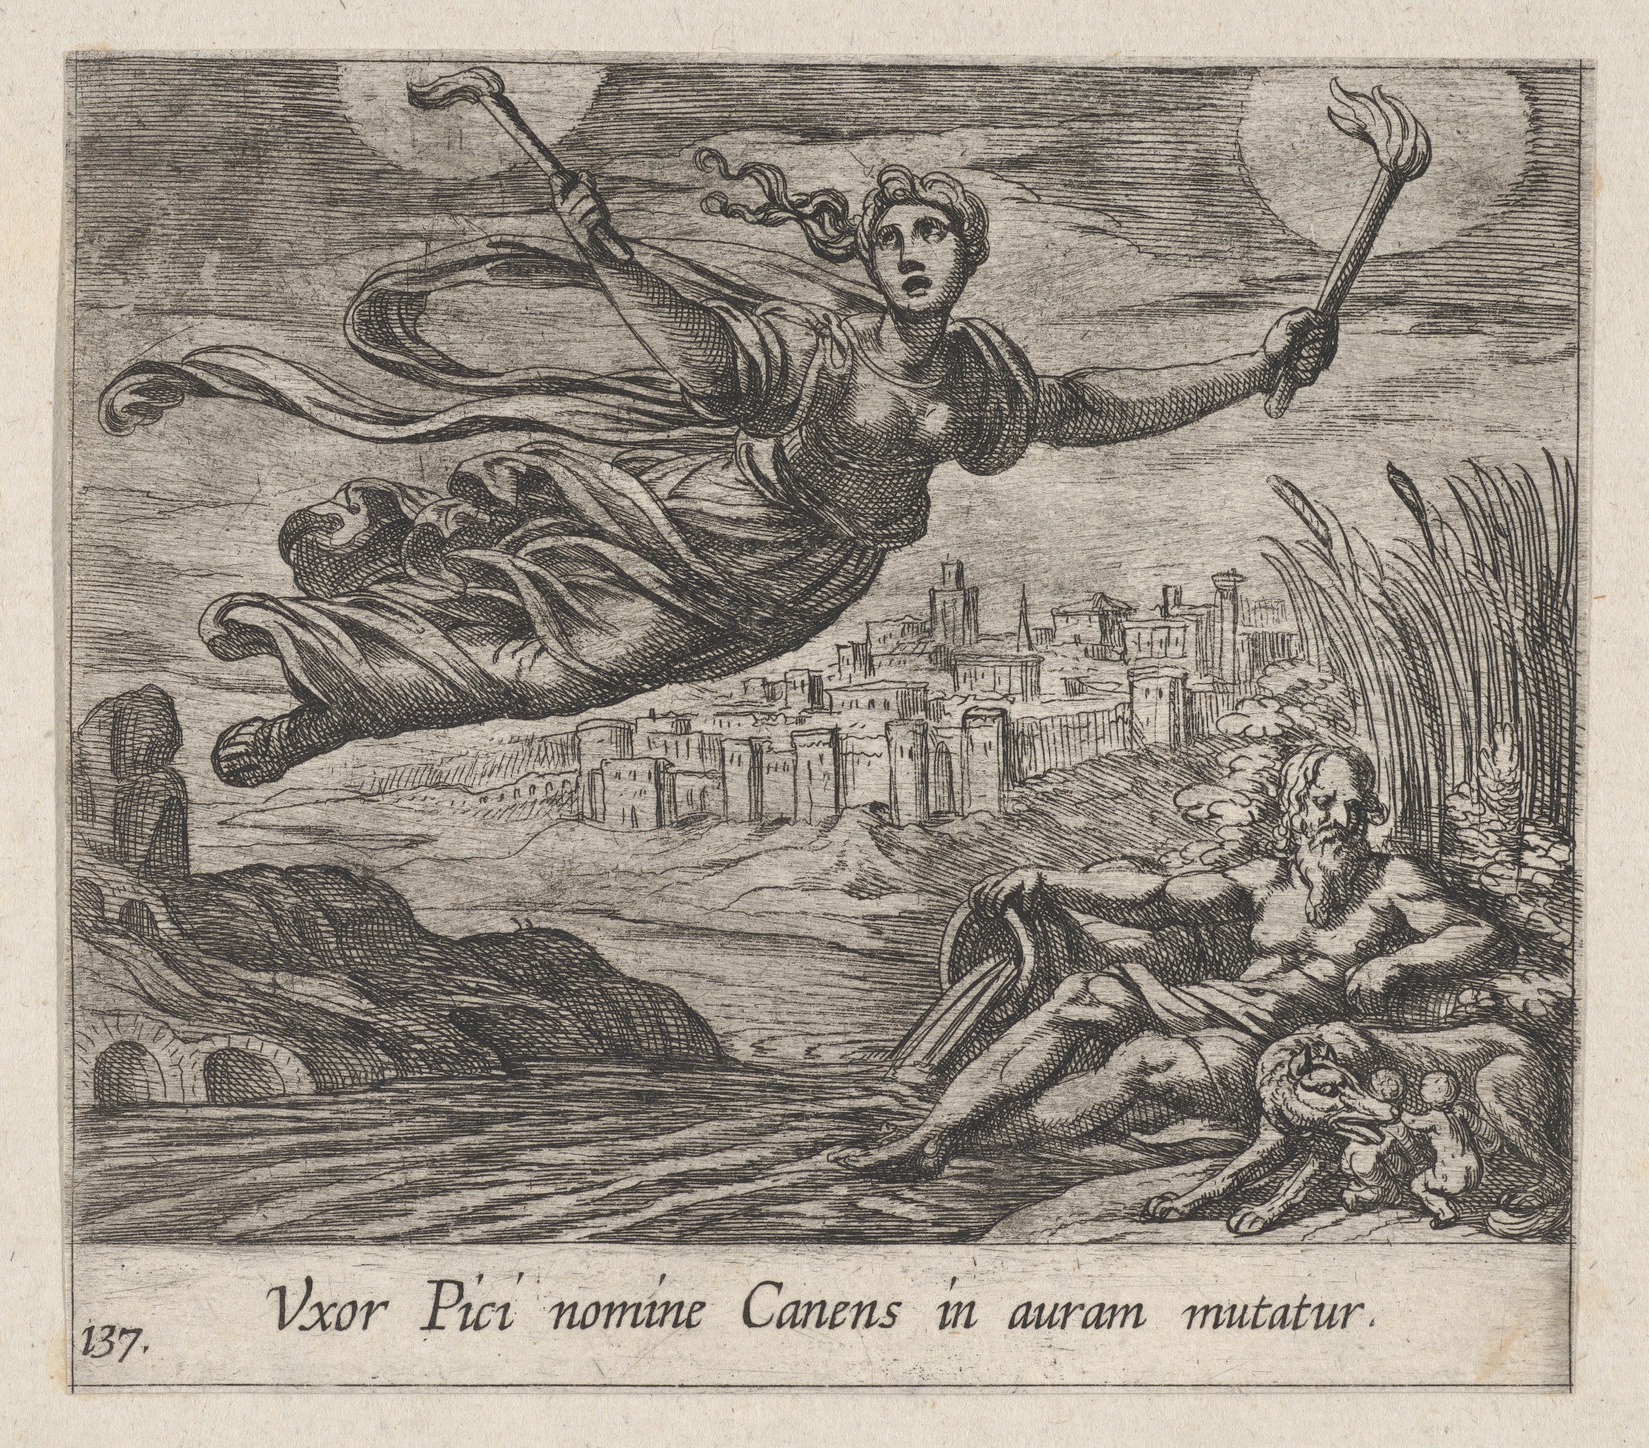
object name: print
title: Plate 137: Canens Searching for Pics (Uxor Pici nomine Canens in auram mutatur), from Ovid's 'Metamorphoses'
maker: antonio tempesta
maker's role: artist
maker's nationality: italian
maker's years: 1555-1630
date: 1606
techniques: etching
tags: animals,buildings,men,nymphs